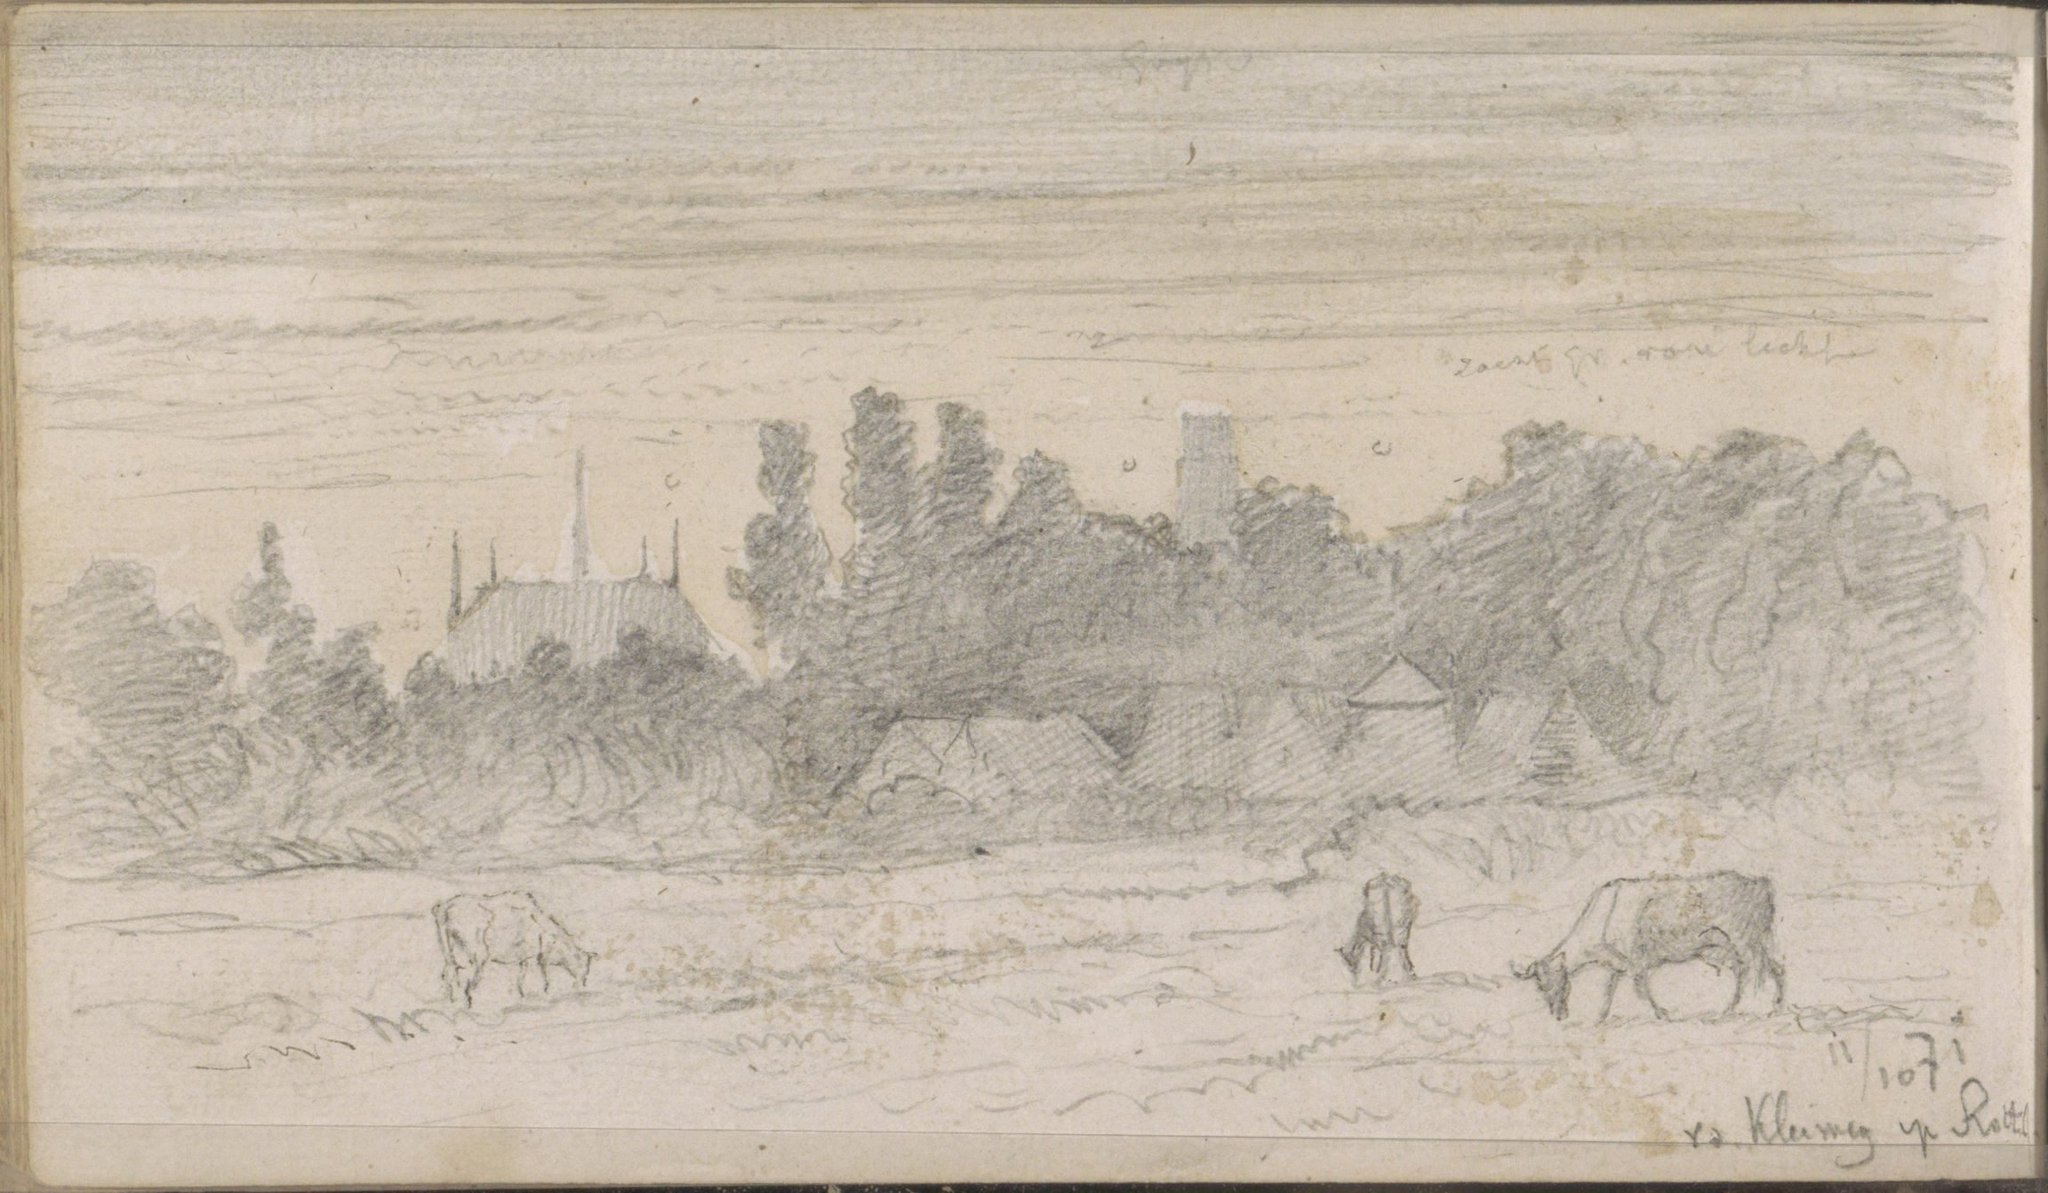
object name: sketchbook leaf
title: Weiland met grazende koeien, gezien vanaf de Kleiweg op de Rotte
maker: johannes tavenraat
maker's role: draughtsman, painter, print maker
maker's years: 1809-1881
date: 1810-1871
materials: ink, paper, pencil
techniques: brush, pen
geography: hillegersberg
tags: city-view, and landscape with man-made constructions, cow, meadow, pasture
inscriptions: date and inscription: ‘11/10 71/ va. Kleiweg op Rotte.’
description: Blad 90 verso uit een schetsboek met 98 bladen.